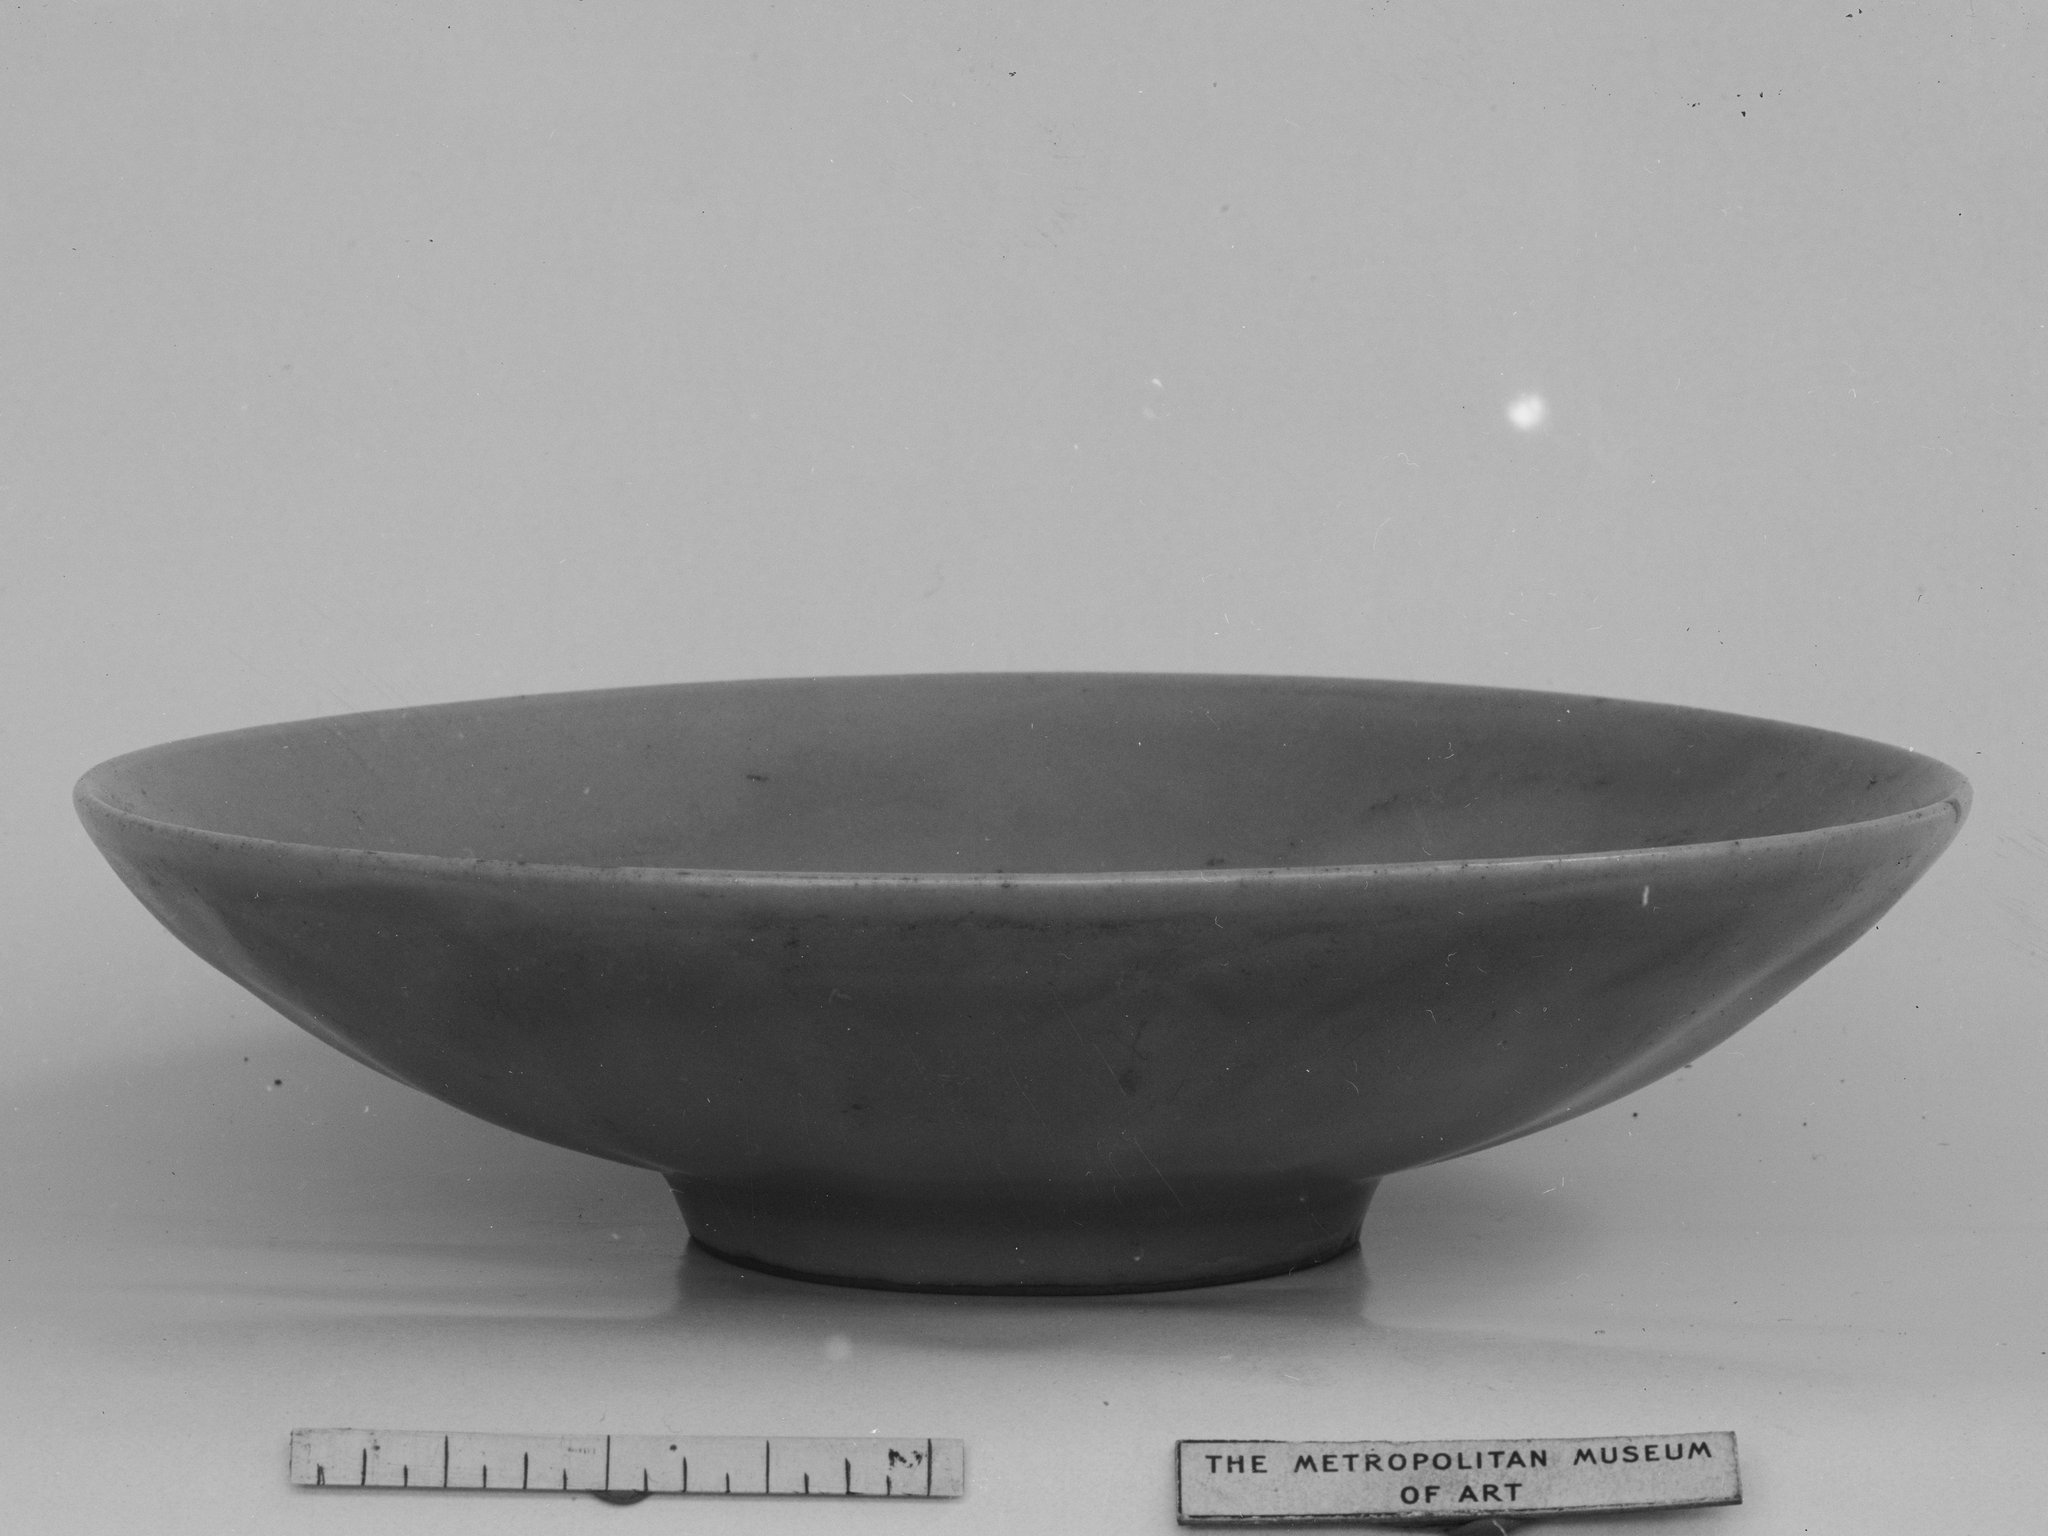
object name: bowl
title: Shallow Bowl Decorated with Lotus Petals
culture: chinese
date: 1127-1279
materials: ceramic glaze, glaze, porcelain